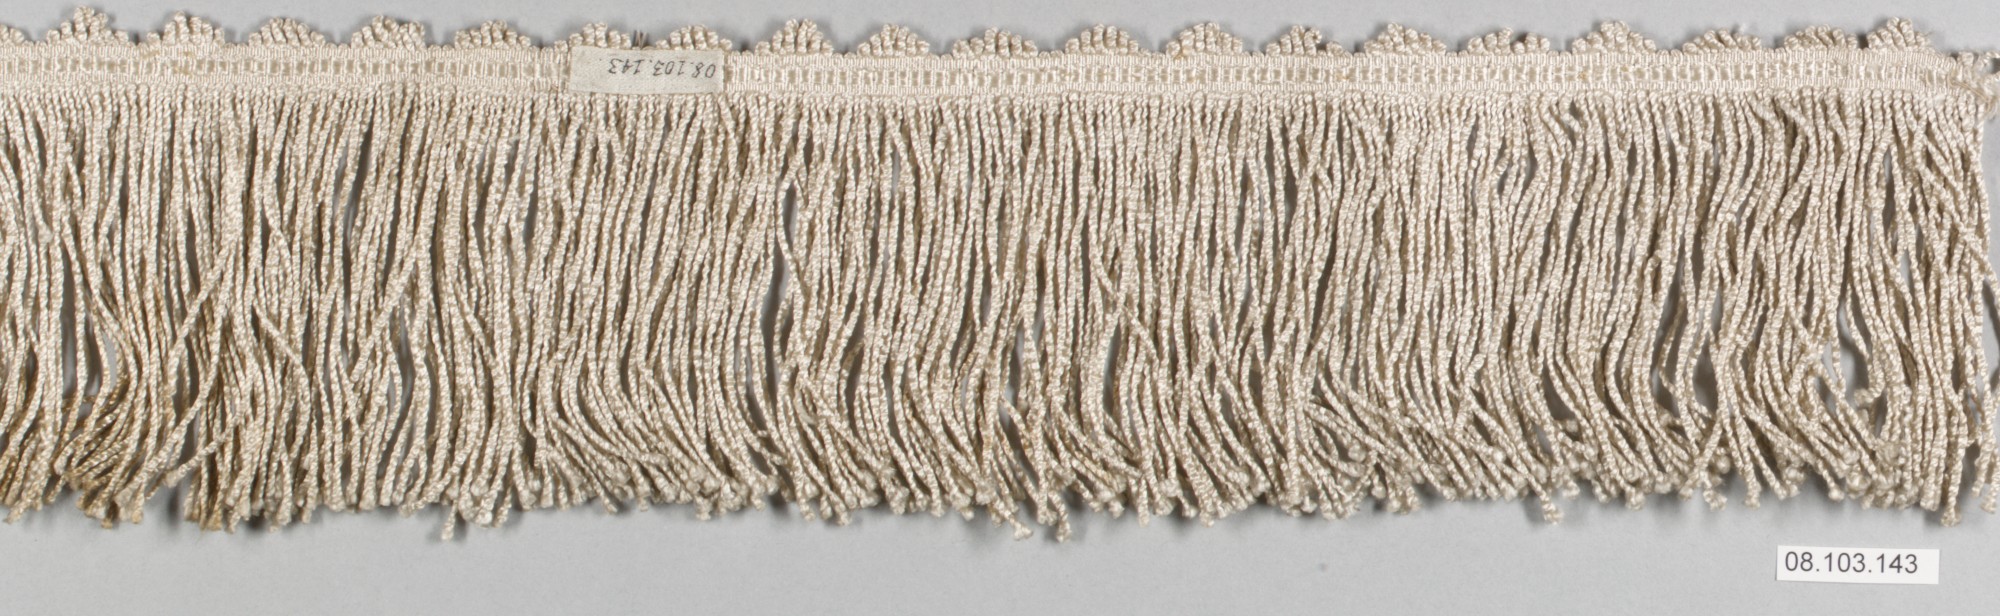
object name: fringe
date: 1880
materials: silk